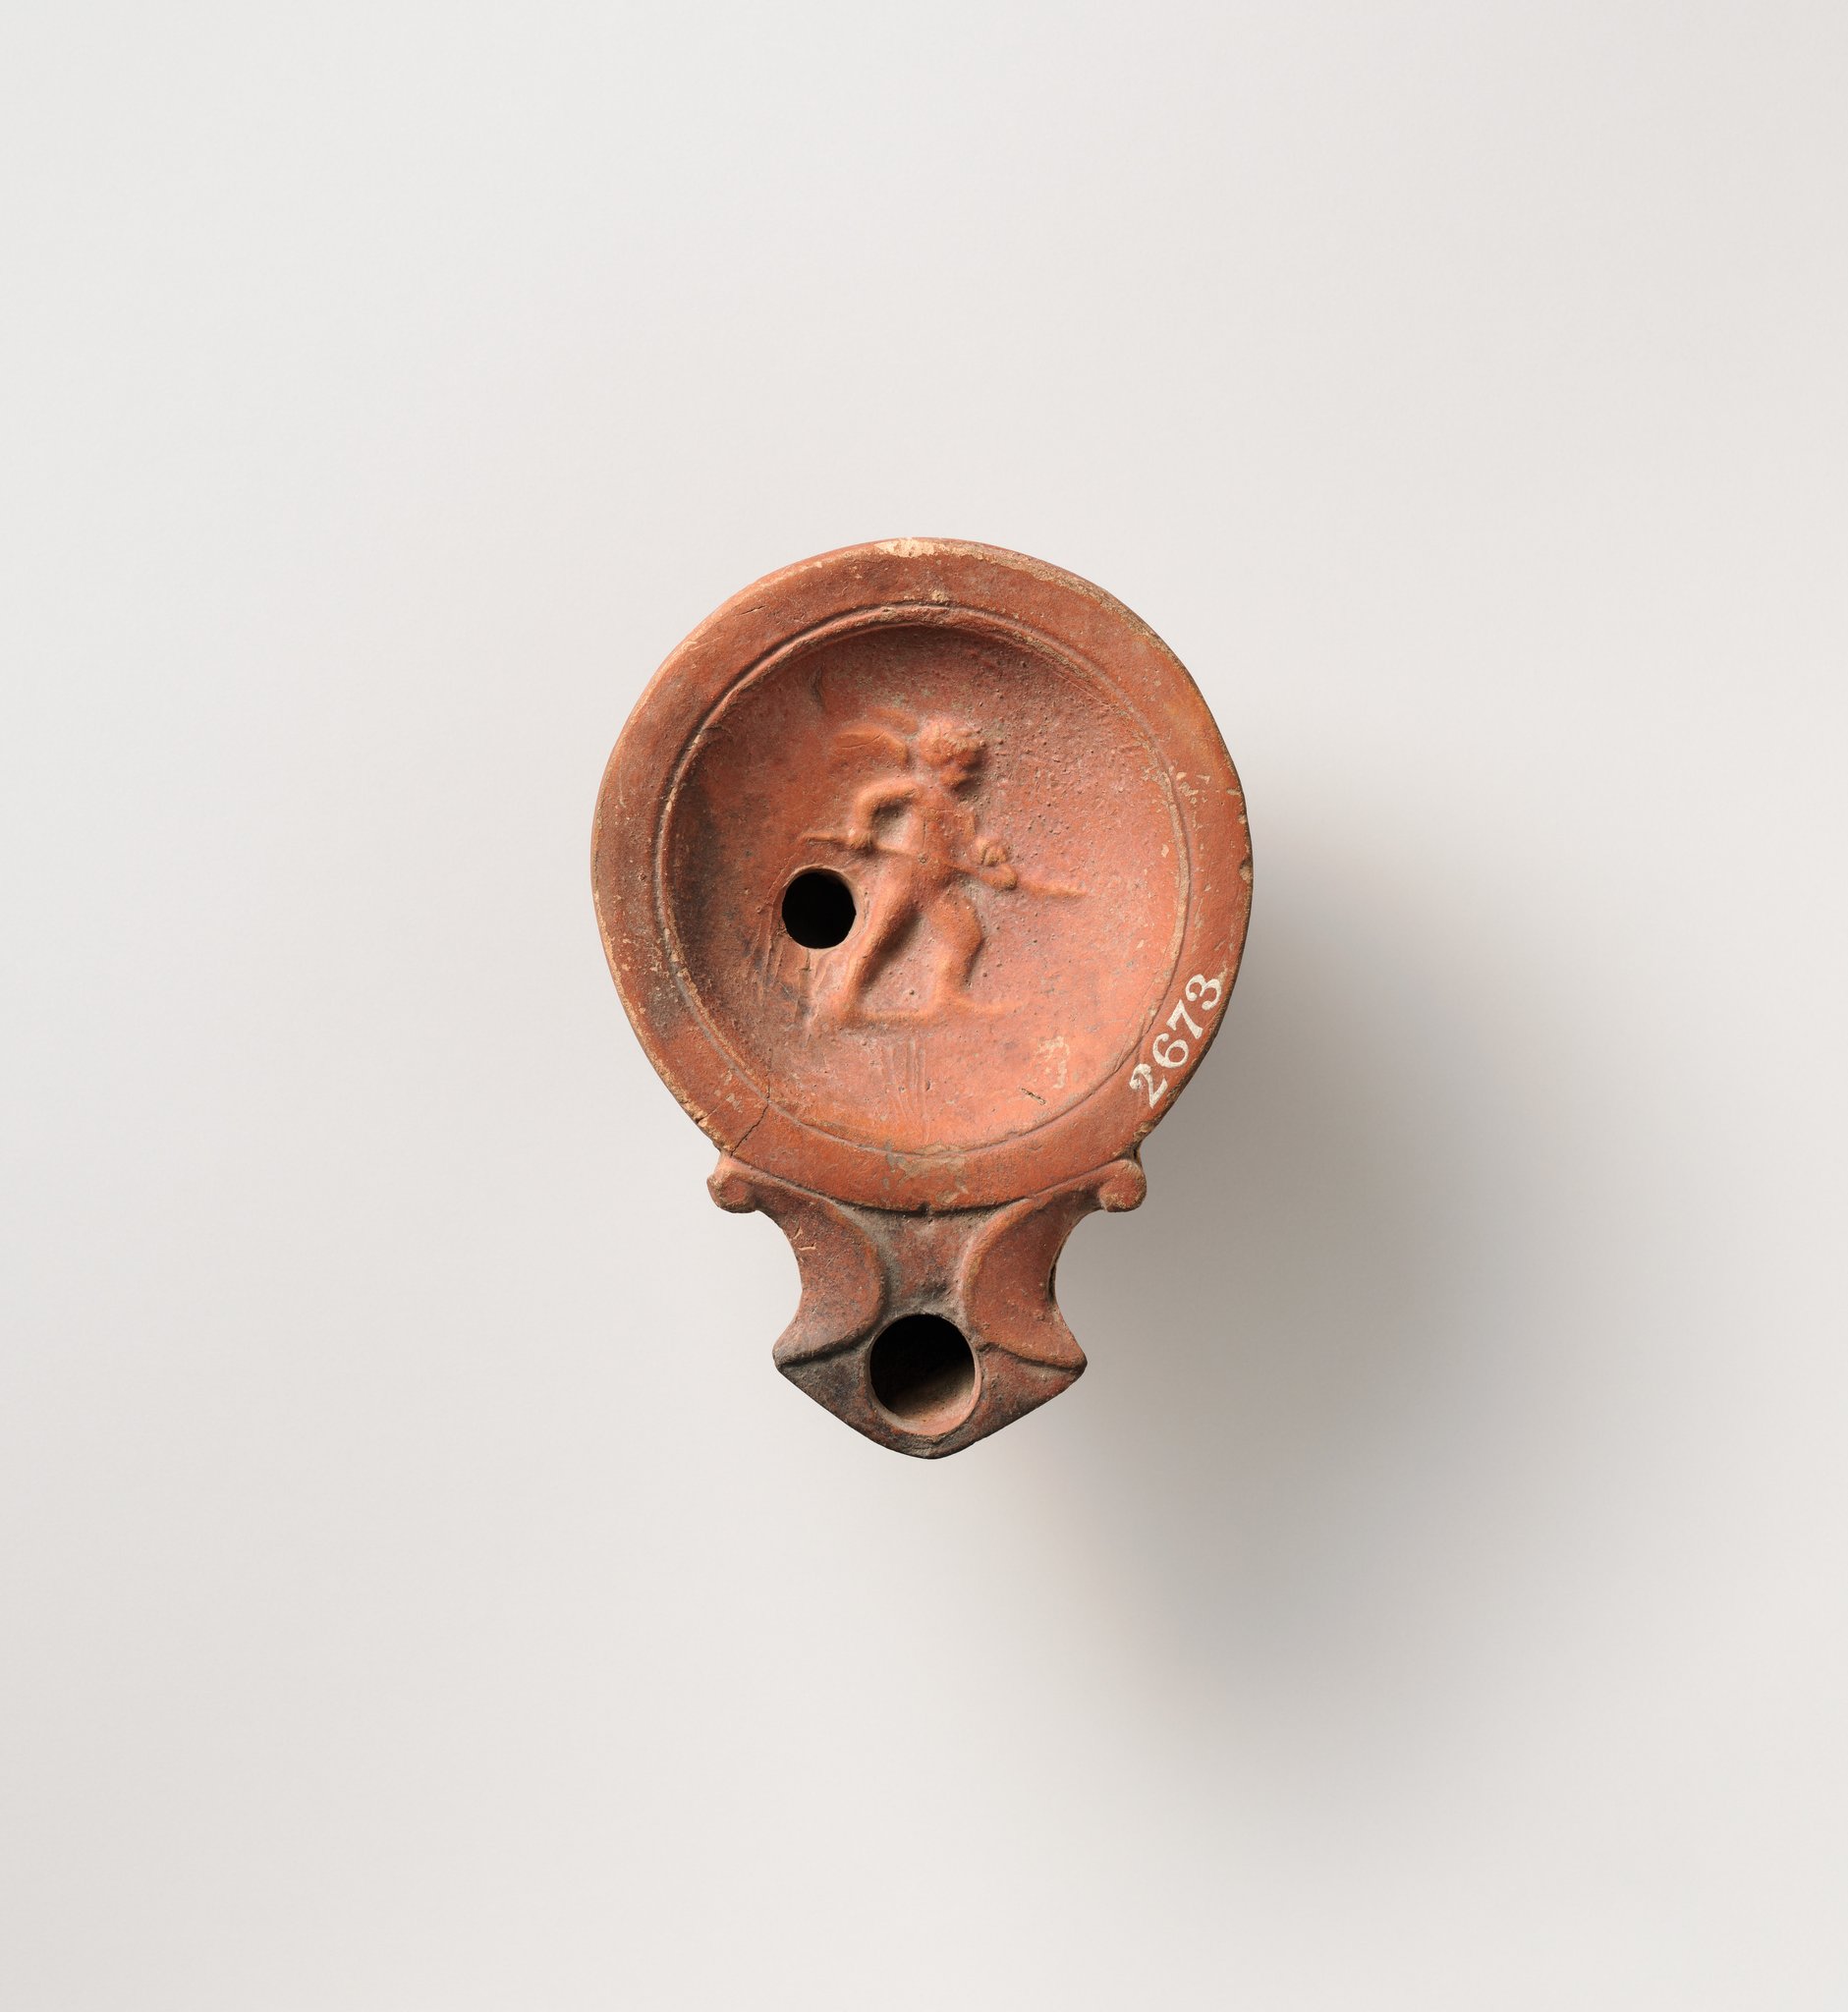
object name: lamp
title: Terracotta oil lamp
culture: roman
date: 100 BCE-100 CE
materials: terracotta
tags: cupid